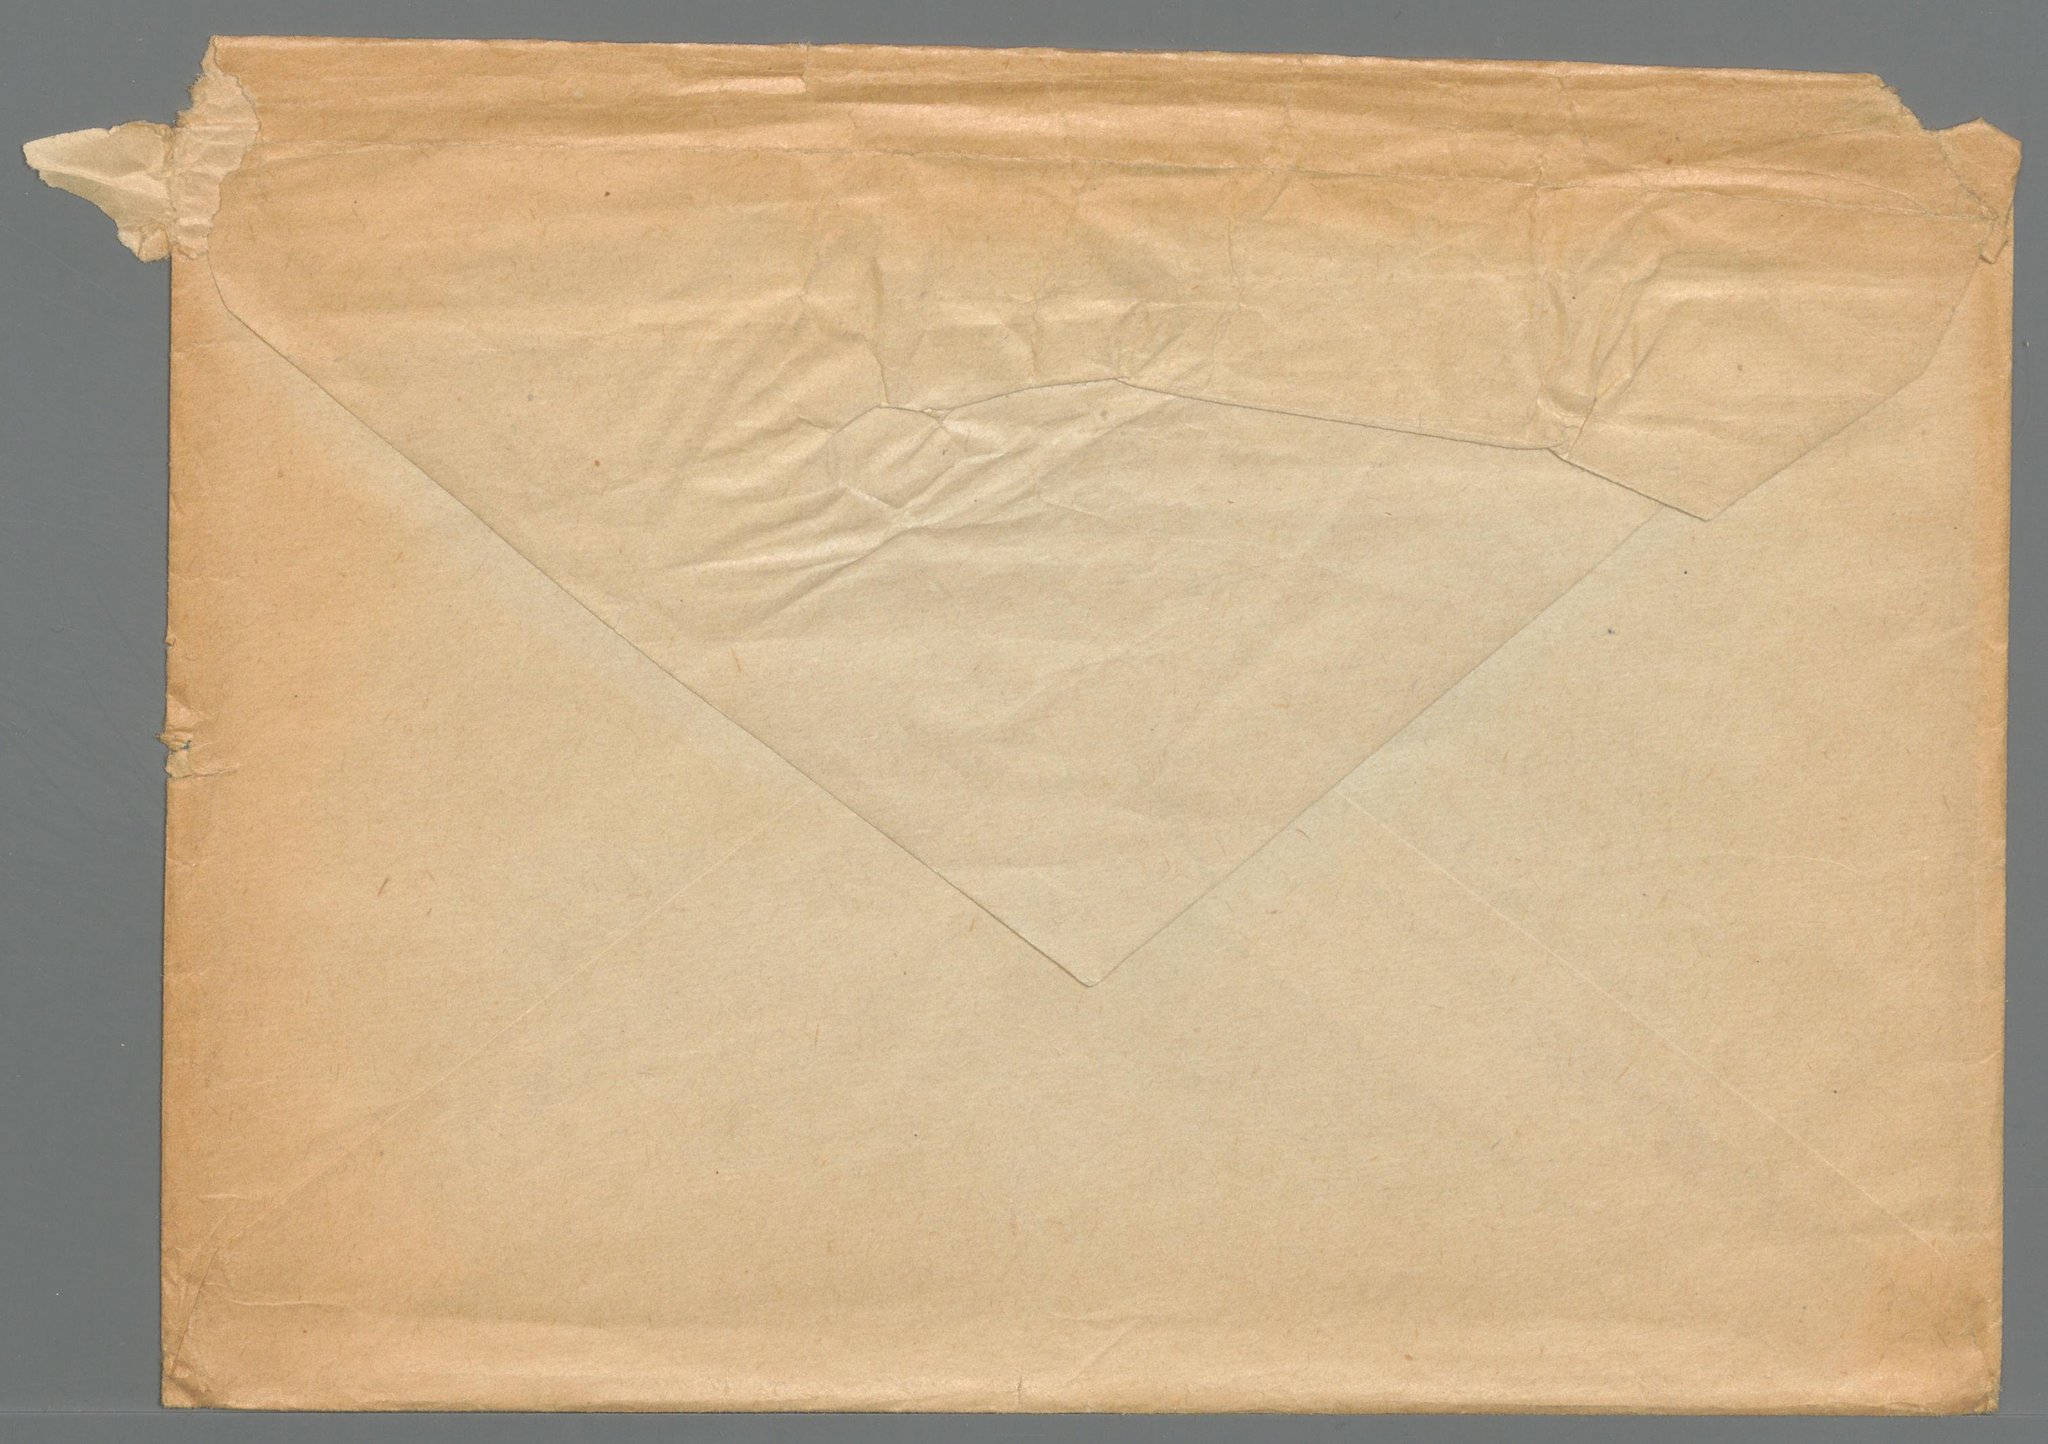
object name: envelope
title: Omslag voor zeven prentbriefkaarten van de Scuola Grande dei Carmini in Venetië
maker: Anonymous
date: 1906-1930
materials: paper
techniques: printing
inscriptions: stamp: ‘Scuola Grande. Arciconfrateria S. Maria del Carmine in Venezia’